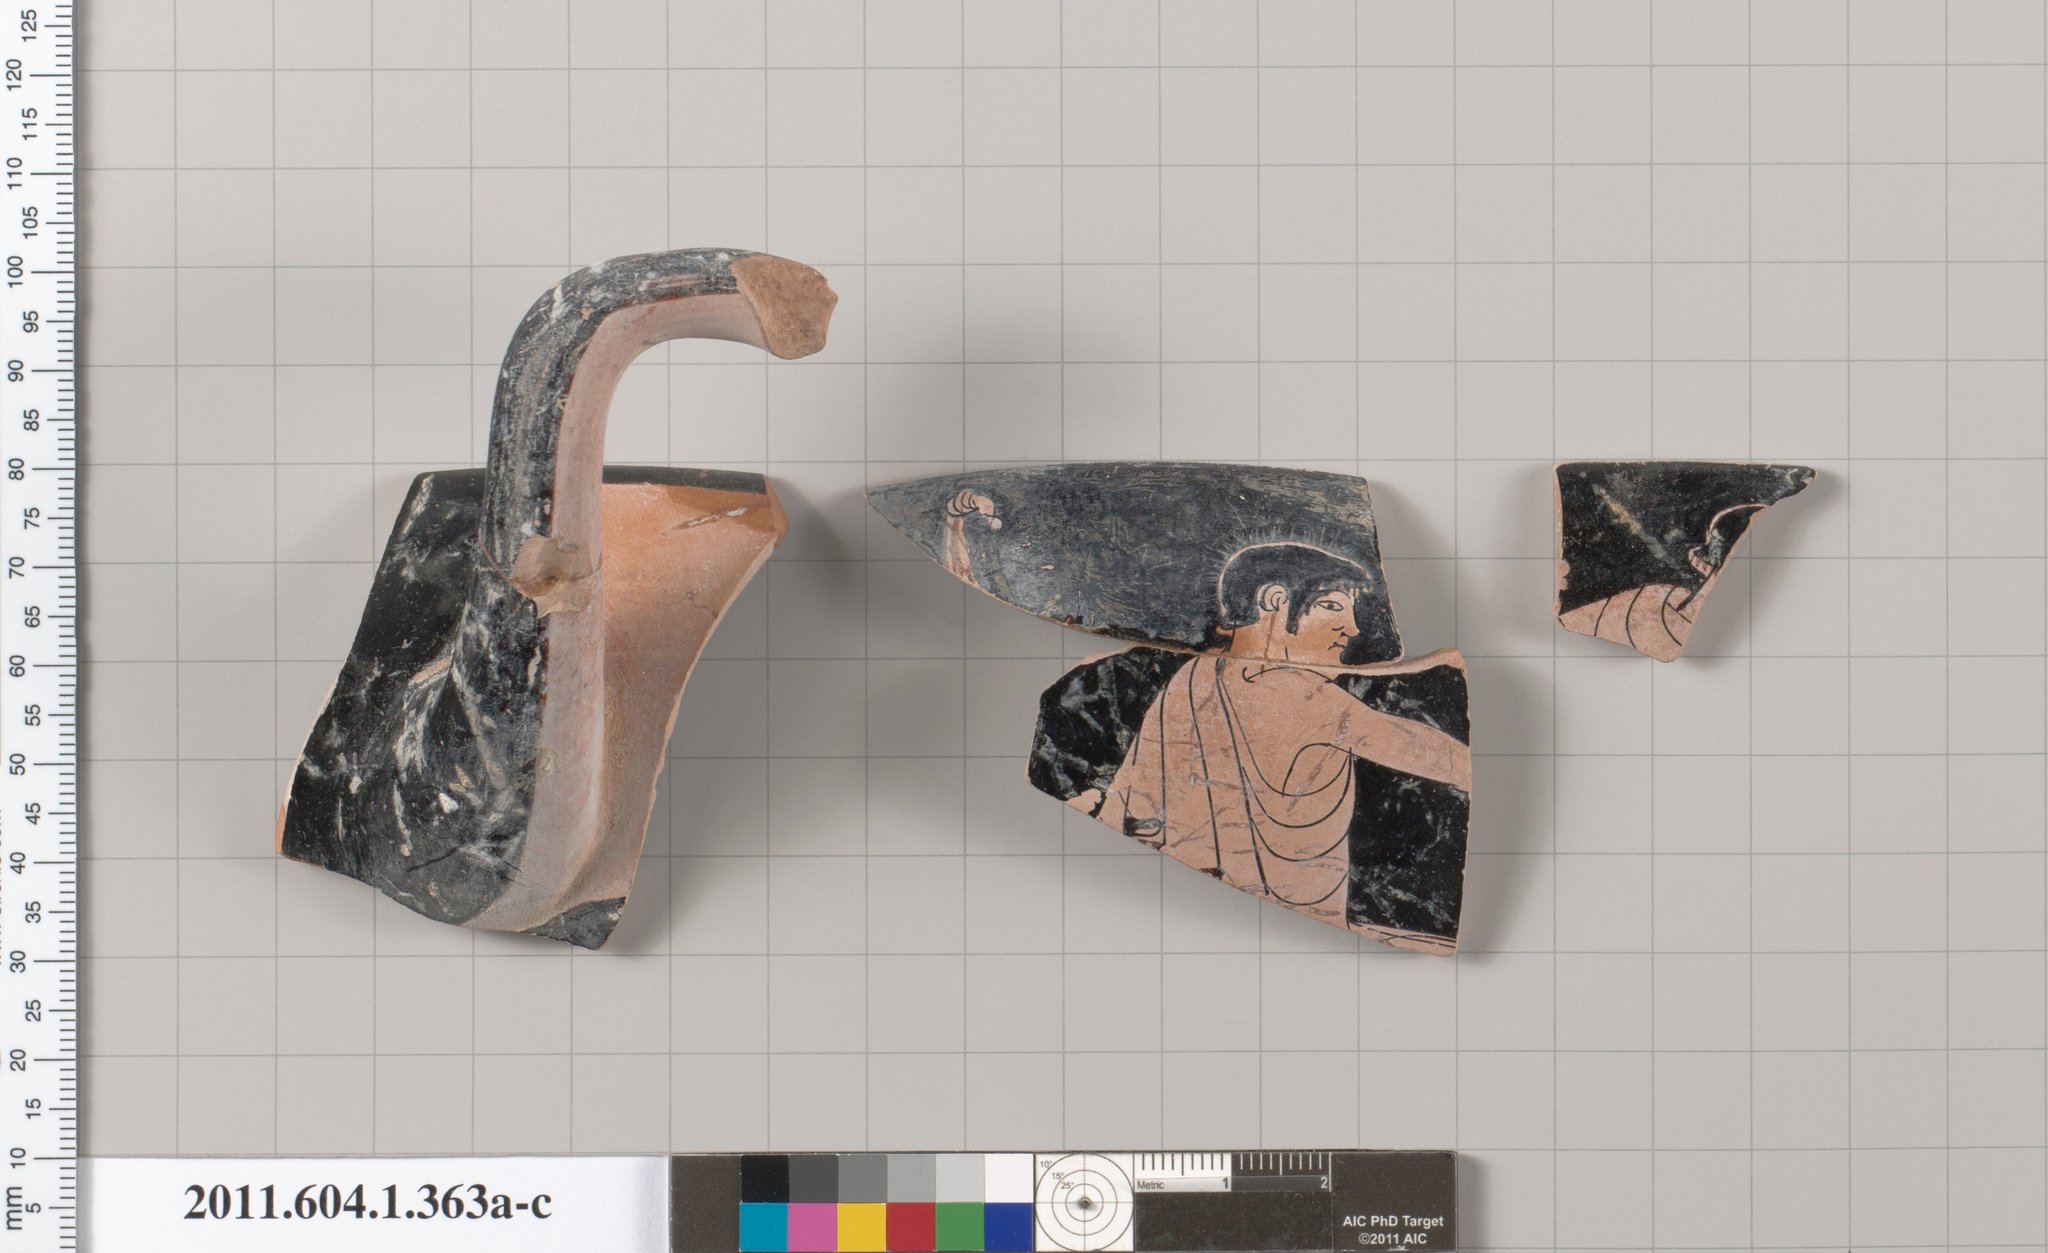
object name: kylix fragment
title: Terracotta fragments of a kylix (drinking cup)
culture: greek, attic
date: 475-451 BCE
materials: terracotta